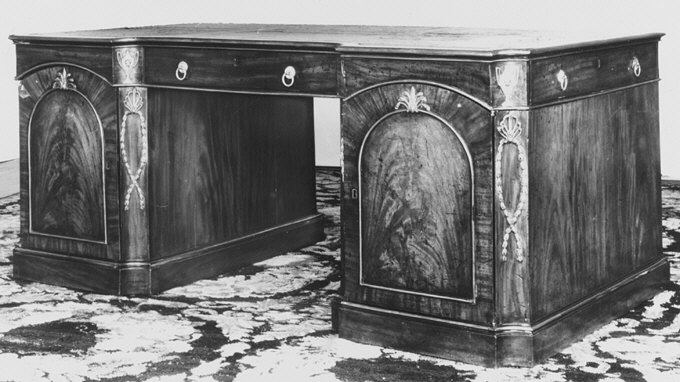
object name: writing table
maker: thomas chippendale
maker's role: designer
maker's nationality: british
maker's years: 1718-1779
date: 1760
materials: gilt bronze, leather, wood